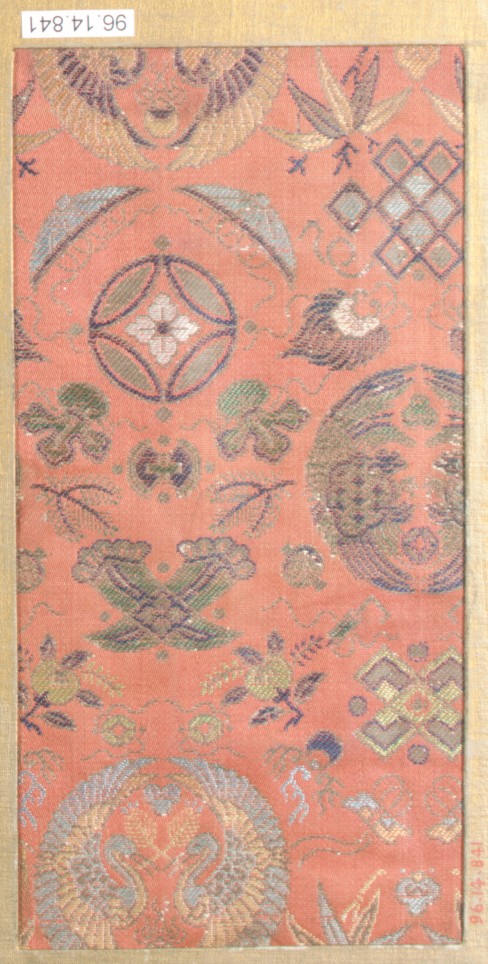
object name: piece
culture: japanese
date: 1701-1900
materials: silk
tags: cranes